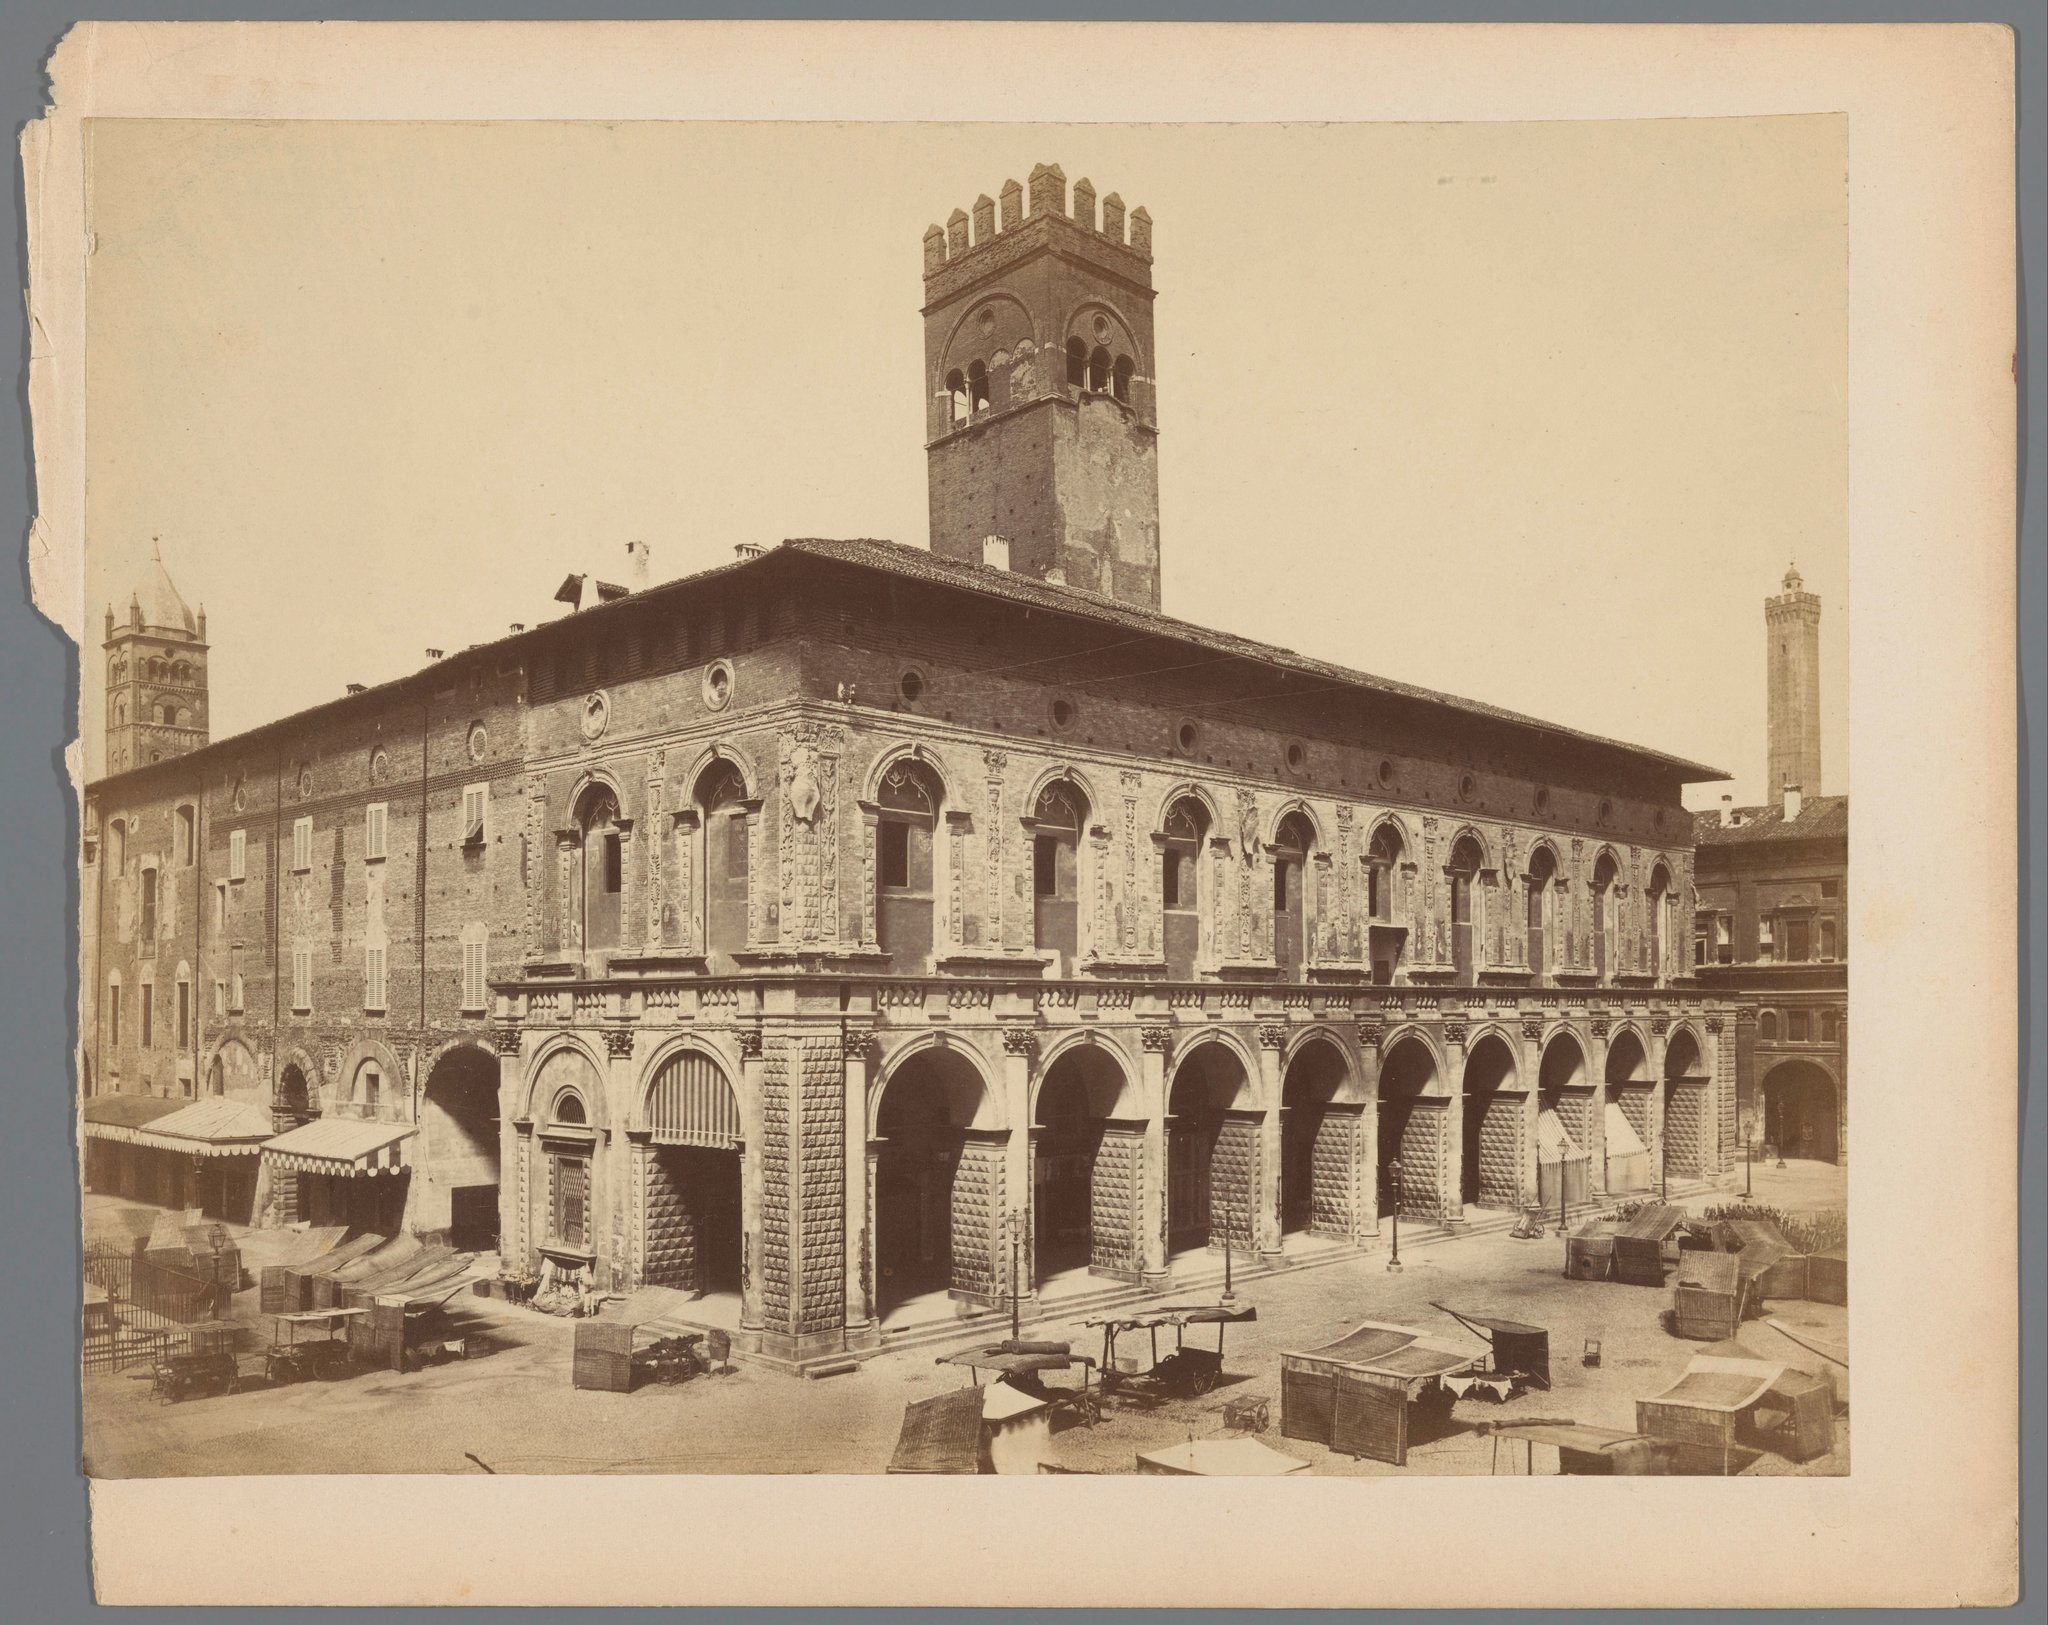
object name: photograph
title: Palazzo del Podestà aan het Piazza Maggiore in Bologna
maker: Anonymous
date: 1875-1900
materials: cardboard, photographic support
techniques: albumen print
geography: bologna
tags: square, place, circus, etc., tower, clock tower ~ monumental adornment, palace, façade (of house or building)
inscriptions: collector's mark: Lugt 3937